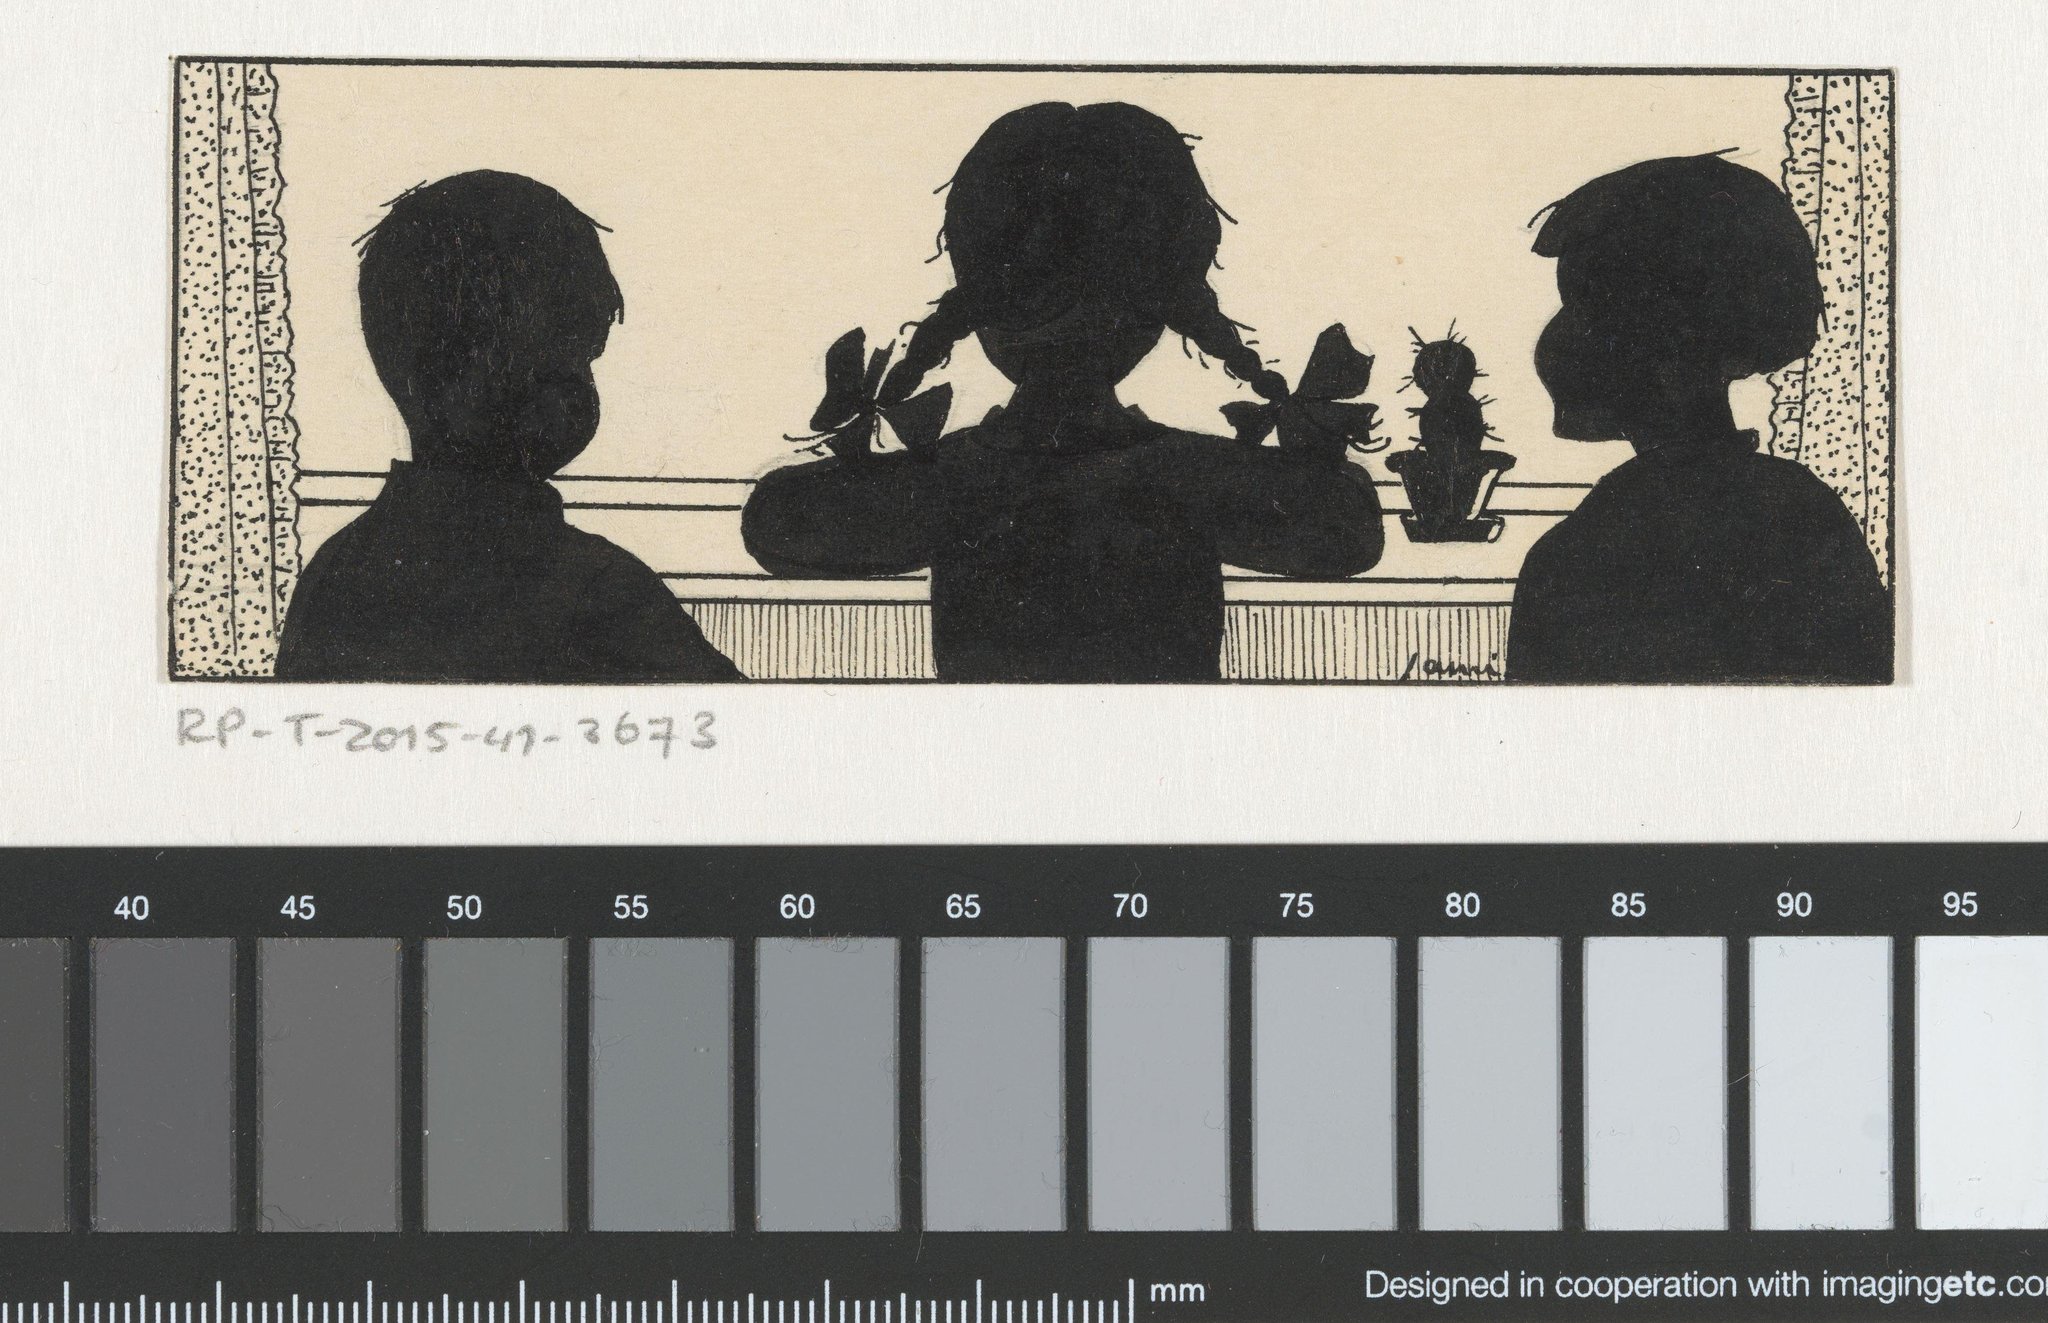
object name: boekillustratie ontwerp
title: Drie kinderen bij een raam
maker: Anonymous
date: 1880-1930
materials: ink, paper, pencil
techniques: brush, pen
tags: plants (in general), child (at home)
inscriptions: signature: ‘lami’, :, collector's mark: Lugt 2228a, annotation: ‘Sint-Nicolaas Dec 2’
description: Een meisje en twee jongens staan bij een raam. In de vensterbank staan potten met planten.